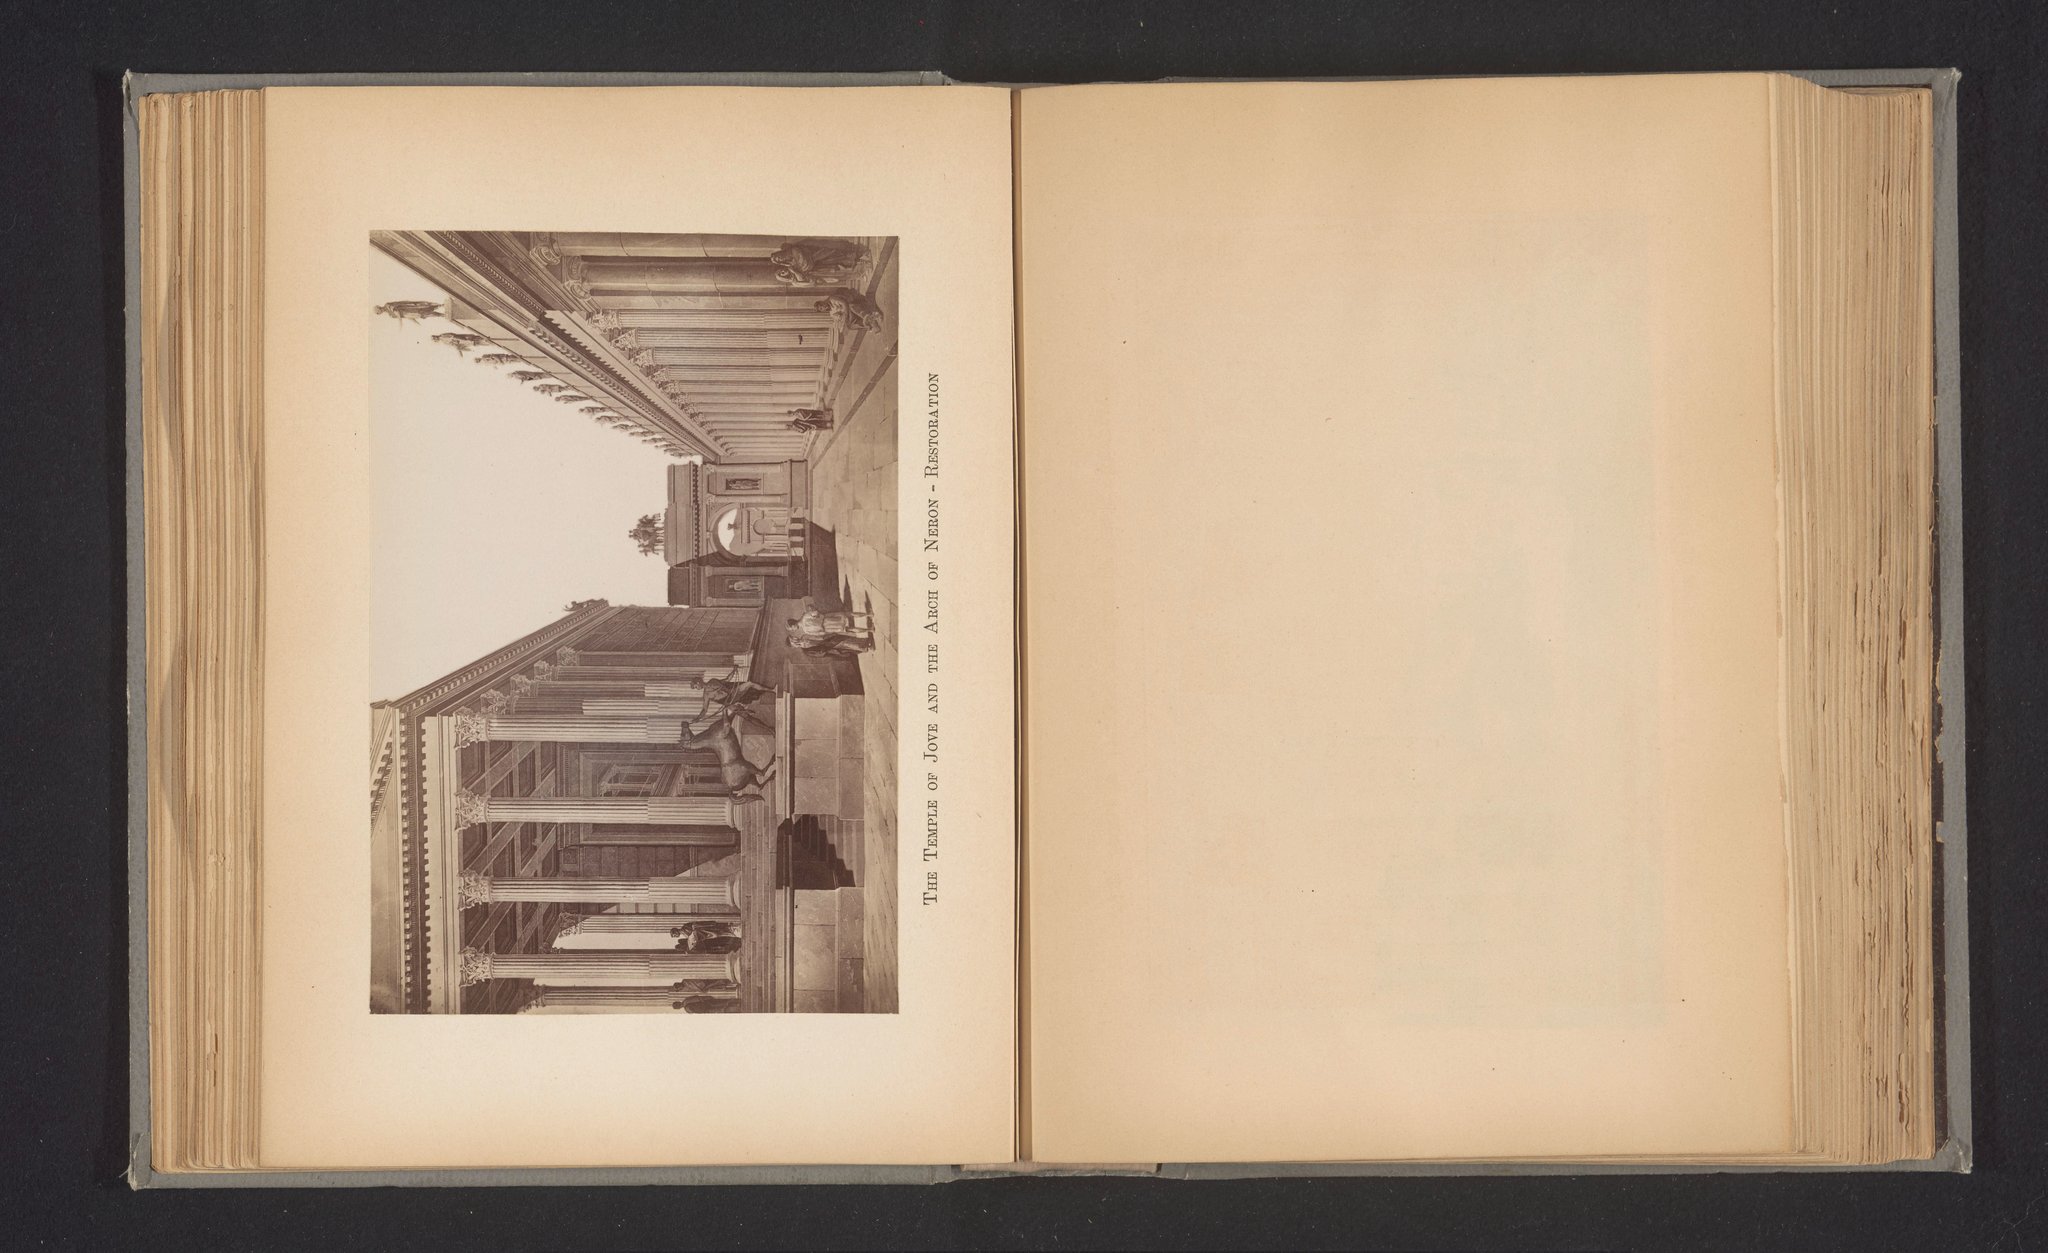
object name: photograph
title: The Temple of Jove and the Arch of Neron - Restoration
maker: Anonymous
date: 1890-1895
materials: photographic support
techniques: albumen print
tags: arch, archivolt ~ architecture, civic architecture; edifices; dwellings